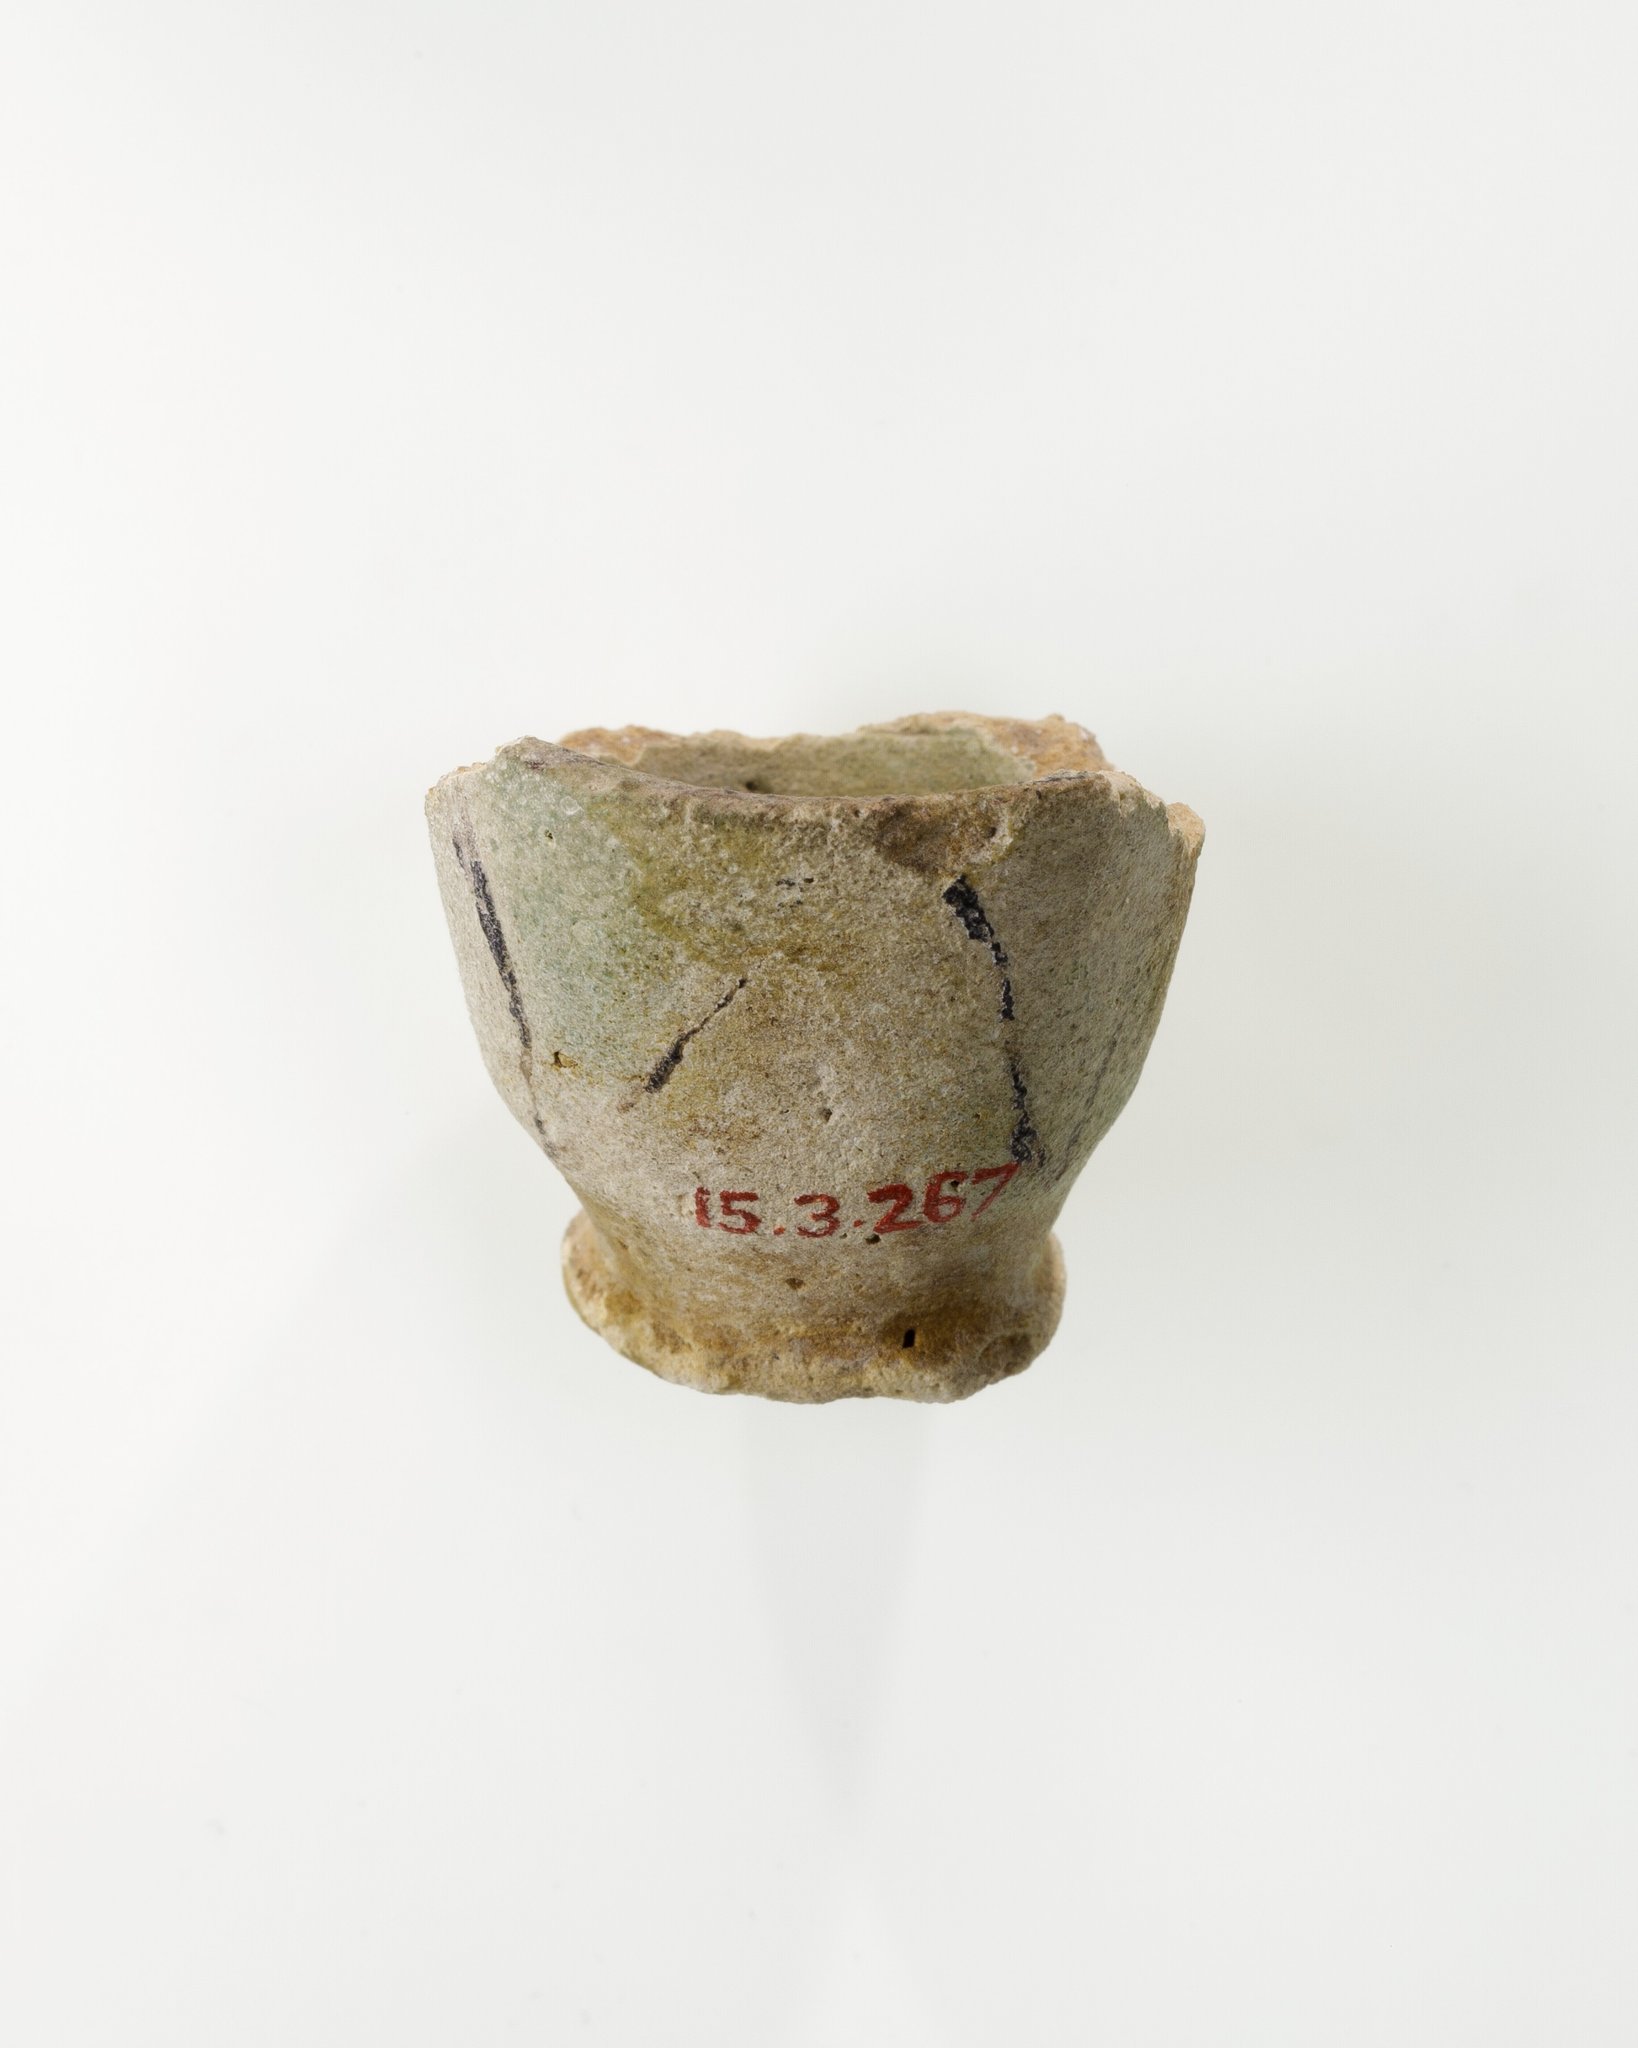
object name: model cup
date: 1900-1850 BCE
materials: faience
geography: egypt